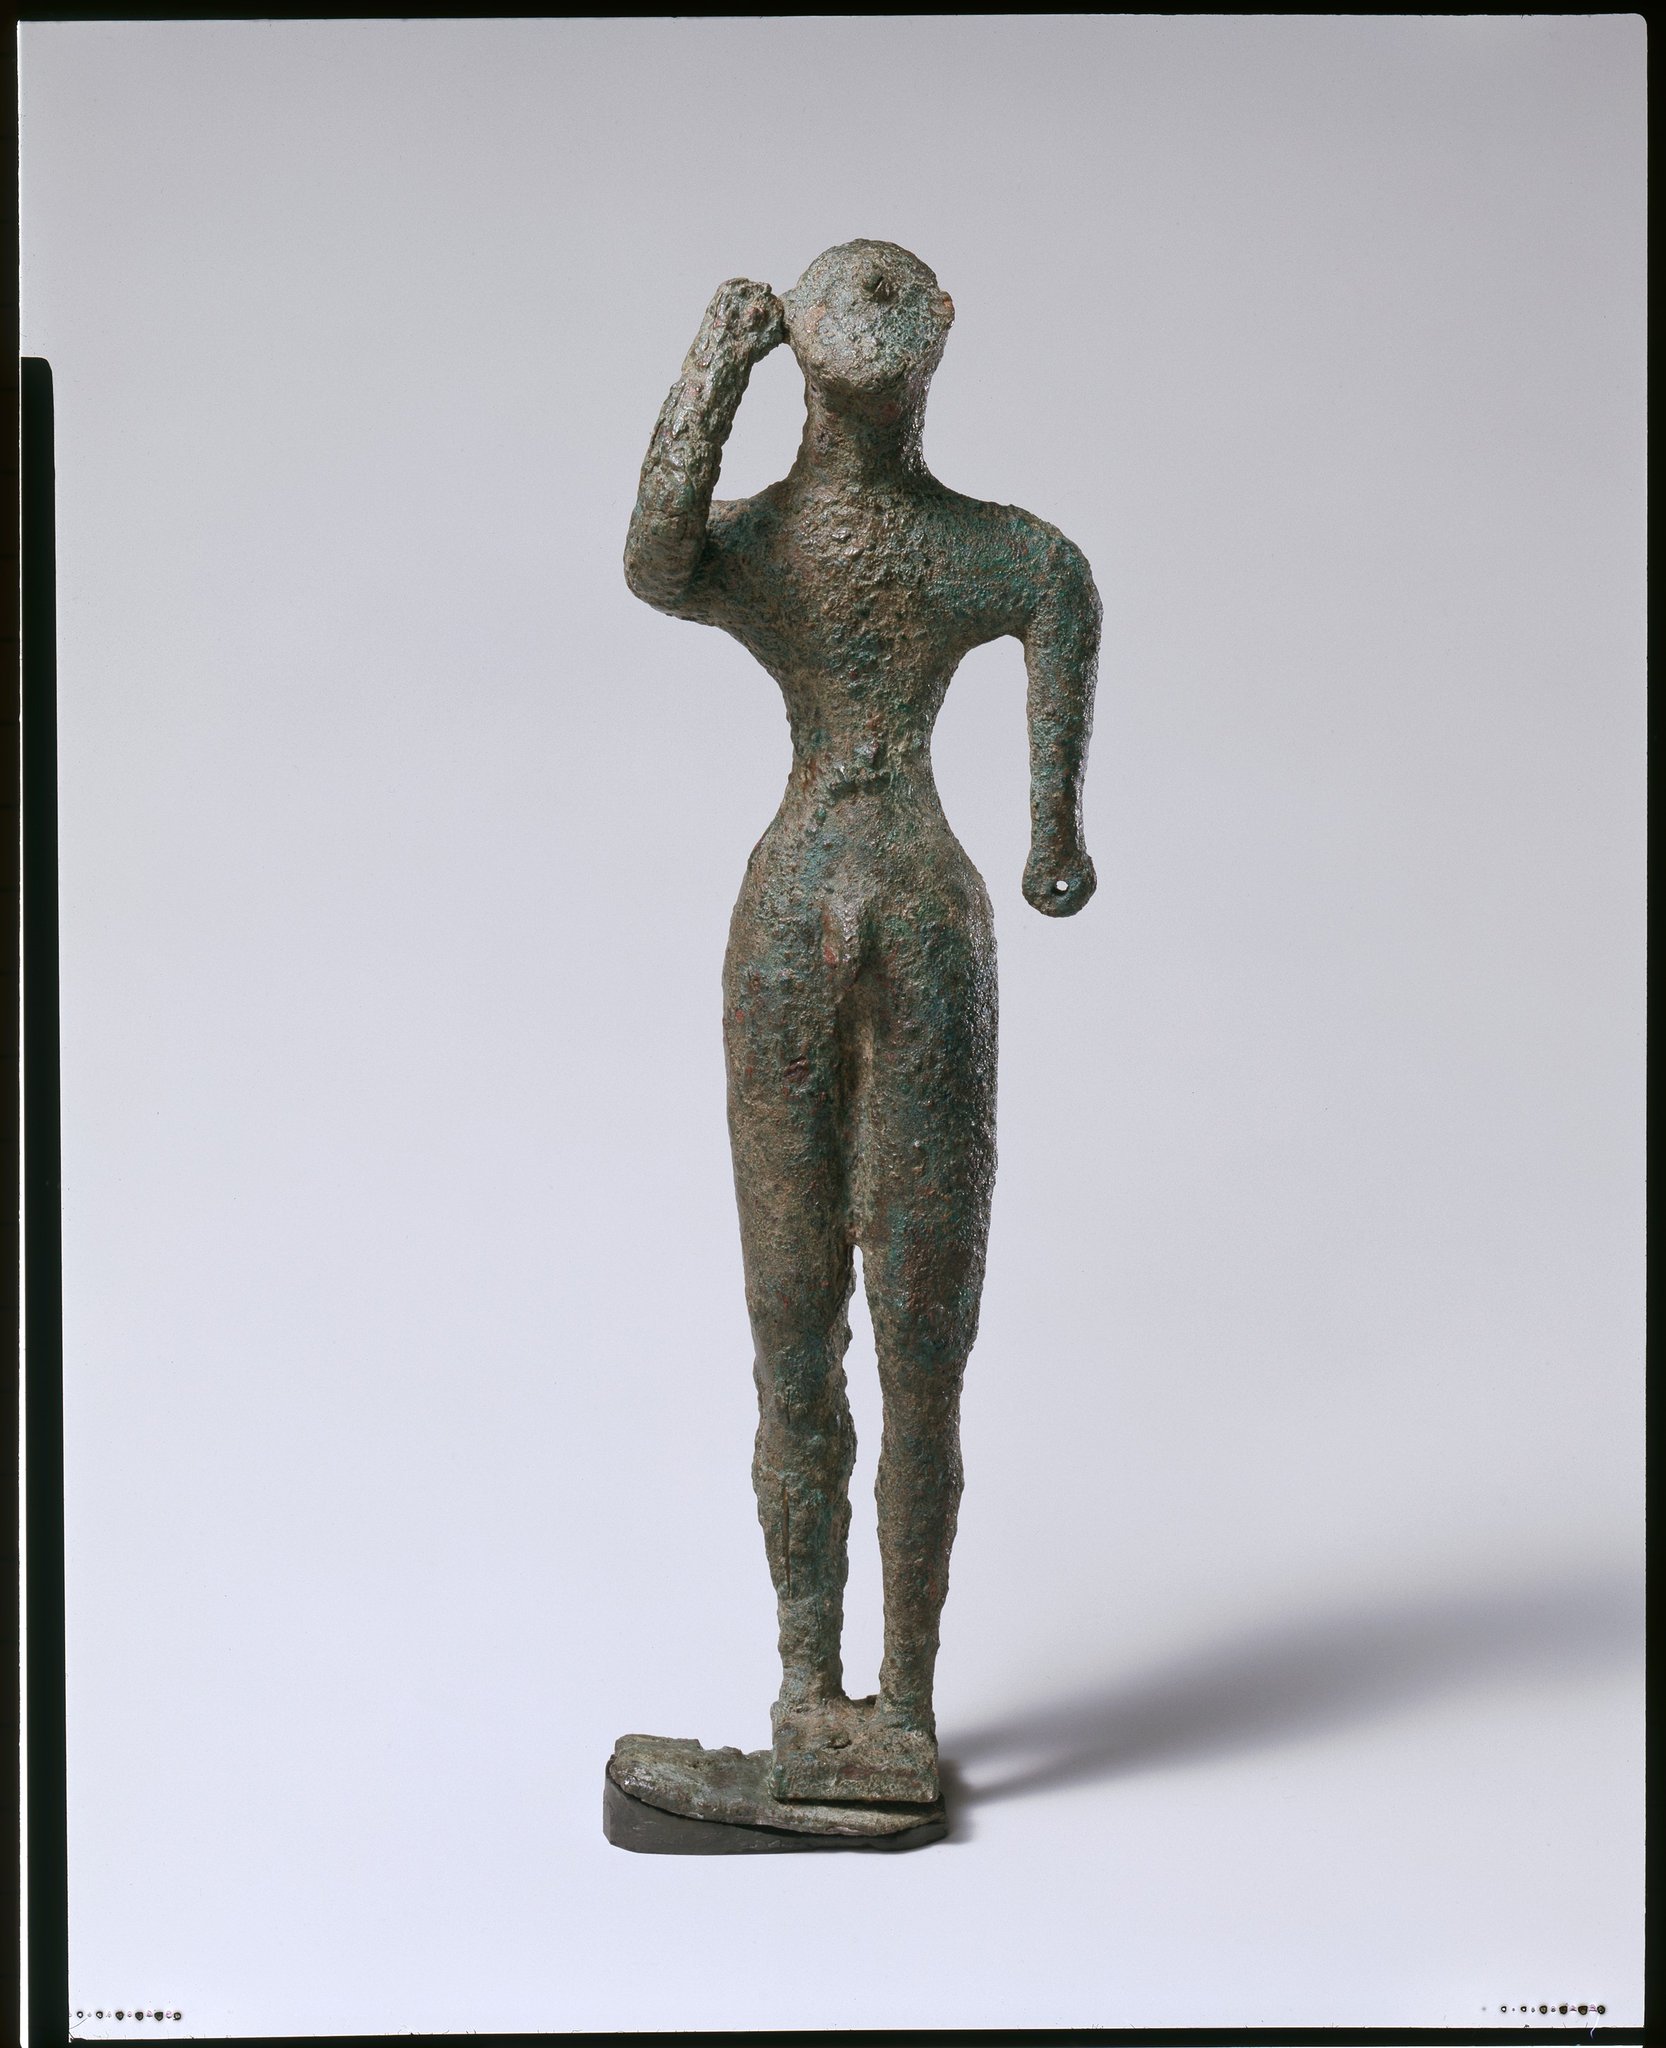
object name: statuette of a warrior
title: Bronze warrior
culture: greek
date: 750-700 BCE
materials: bronze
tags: warriors